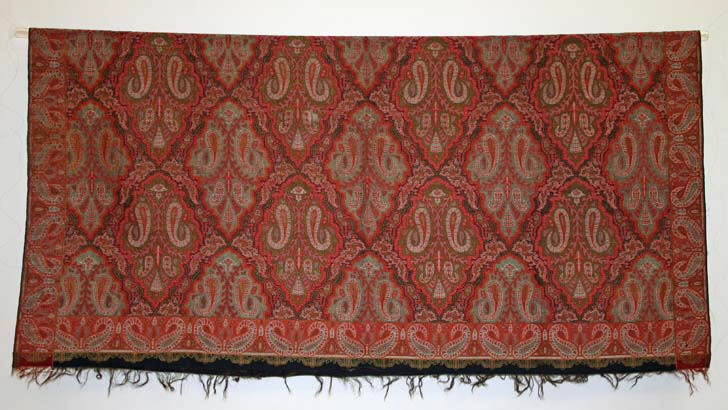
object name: shawl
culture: french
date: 1851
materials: metal thread, silk, wool